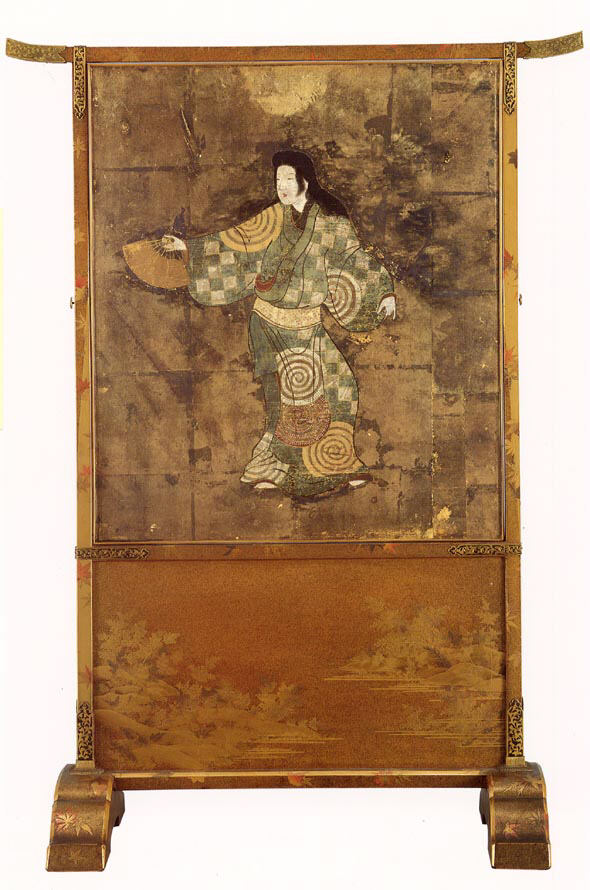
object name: screen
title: Freestanding Screen with Dancer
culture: japanese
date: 1601-1700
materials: gilt, gold, ink, paper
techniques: lacquer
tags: fans,women,dancers